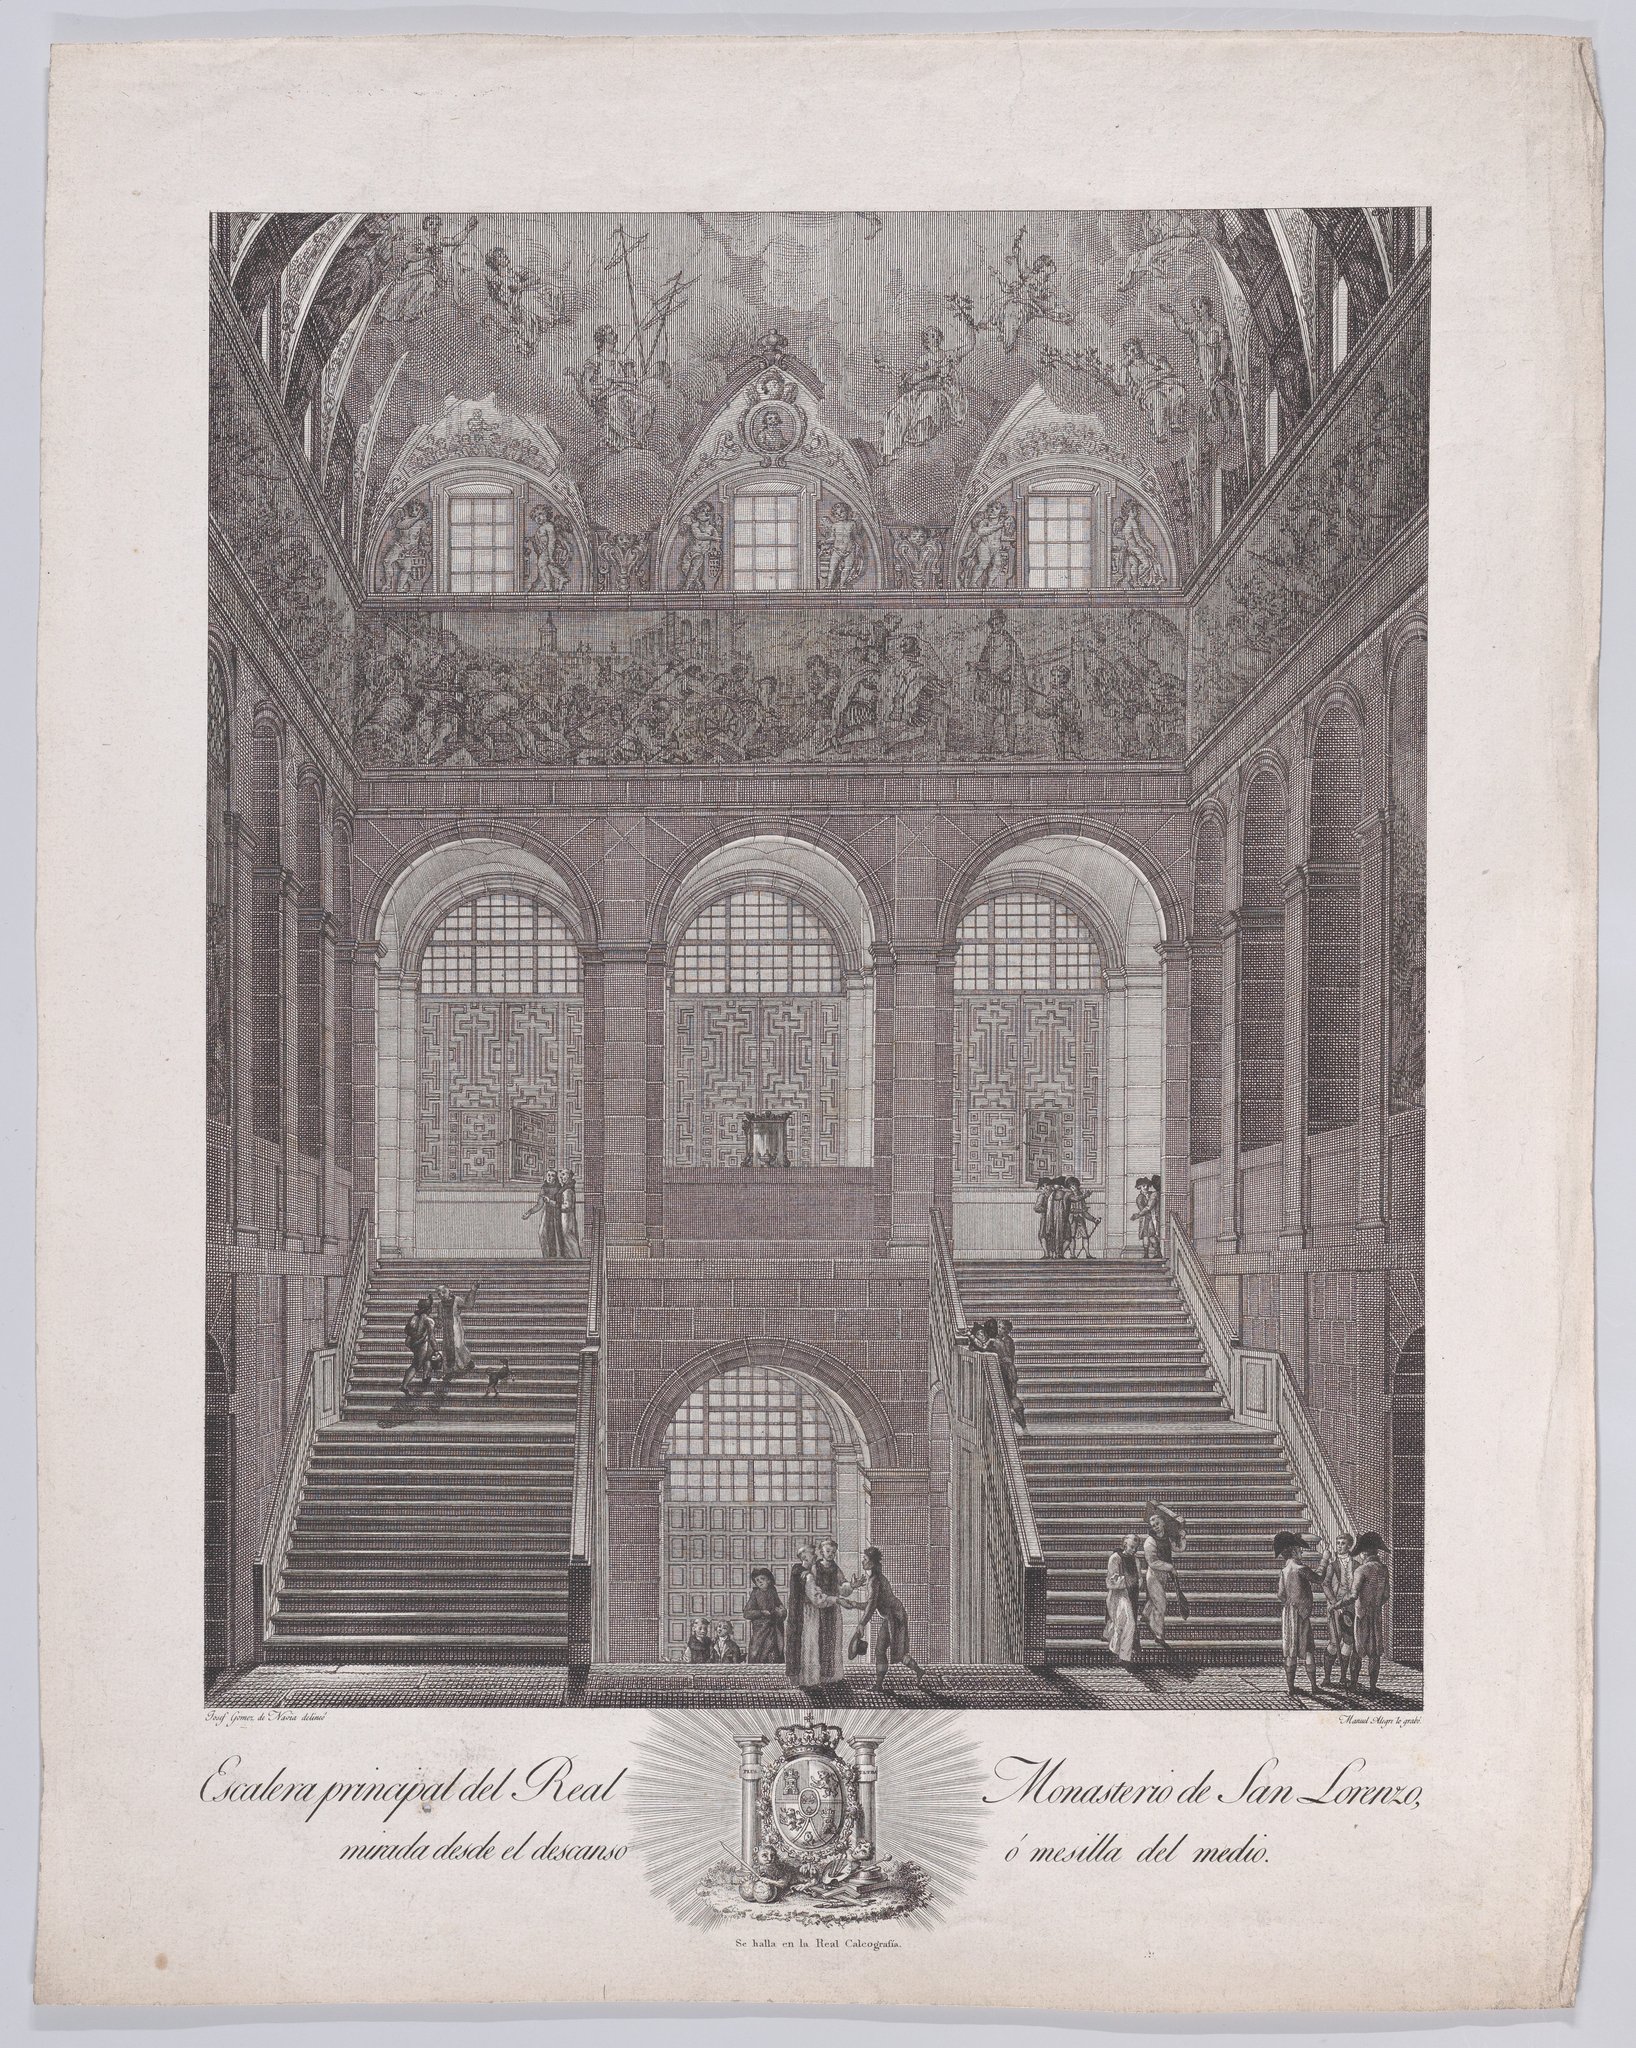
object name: print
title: The main staircase of the monastery of El Escorial, from "Views of El Escorial"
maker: manuel alegre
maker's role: artist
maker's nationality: spanish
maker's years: 1768-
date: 1790-1800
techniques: engraving, etching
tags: stairs,interiors